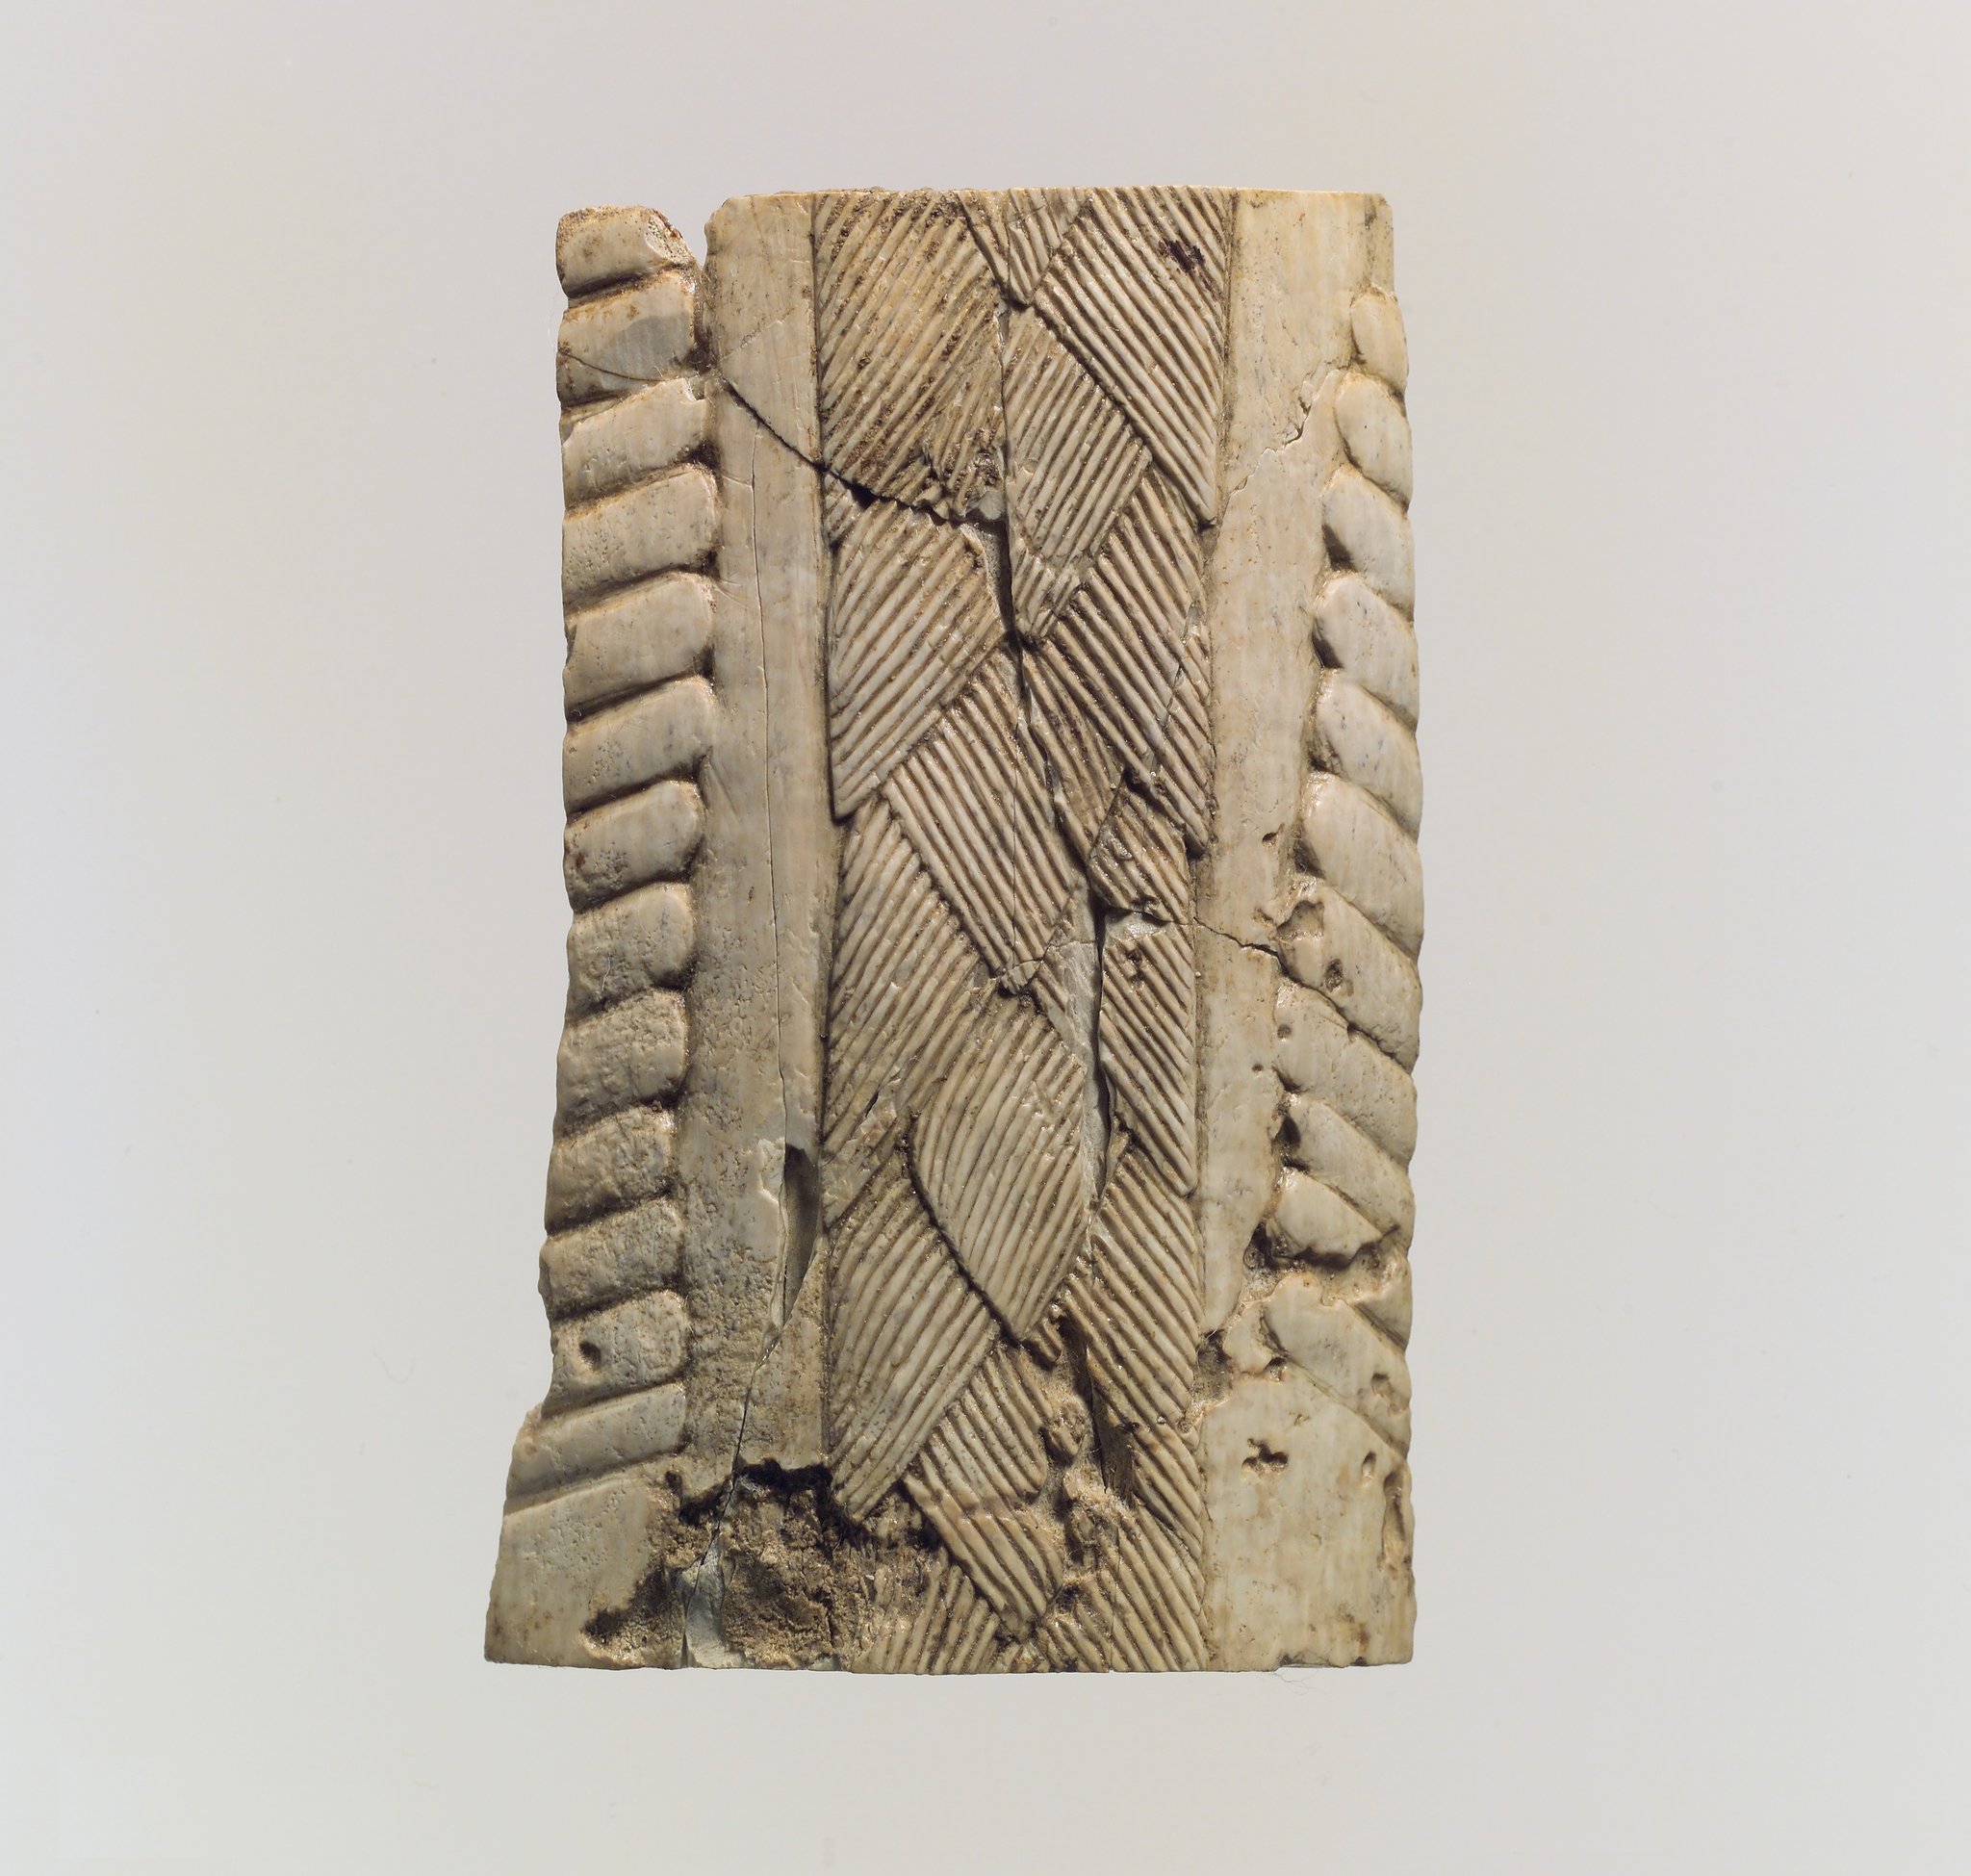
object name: relief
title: Ivory fragment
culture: assyrian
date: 900-601 BCE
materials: ivory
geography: mesopotamia